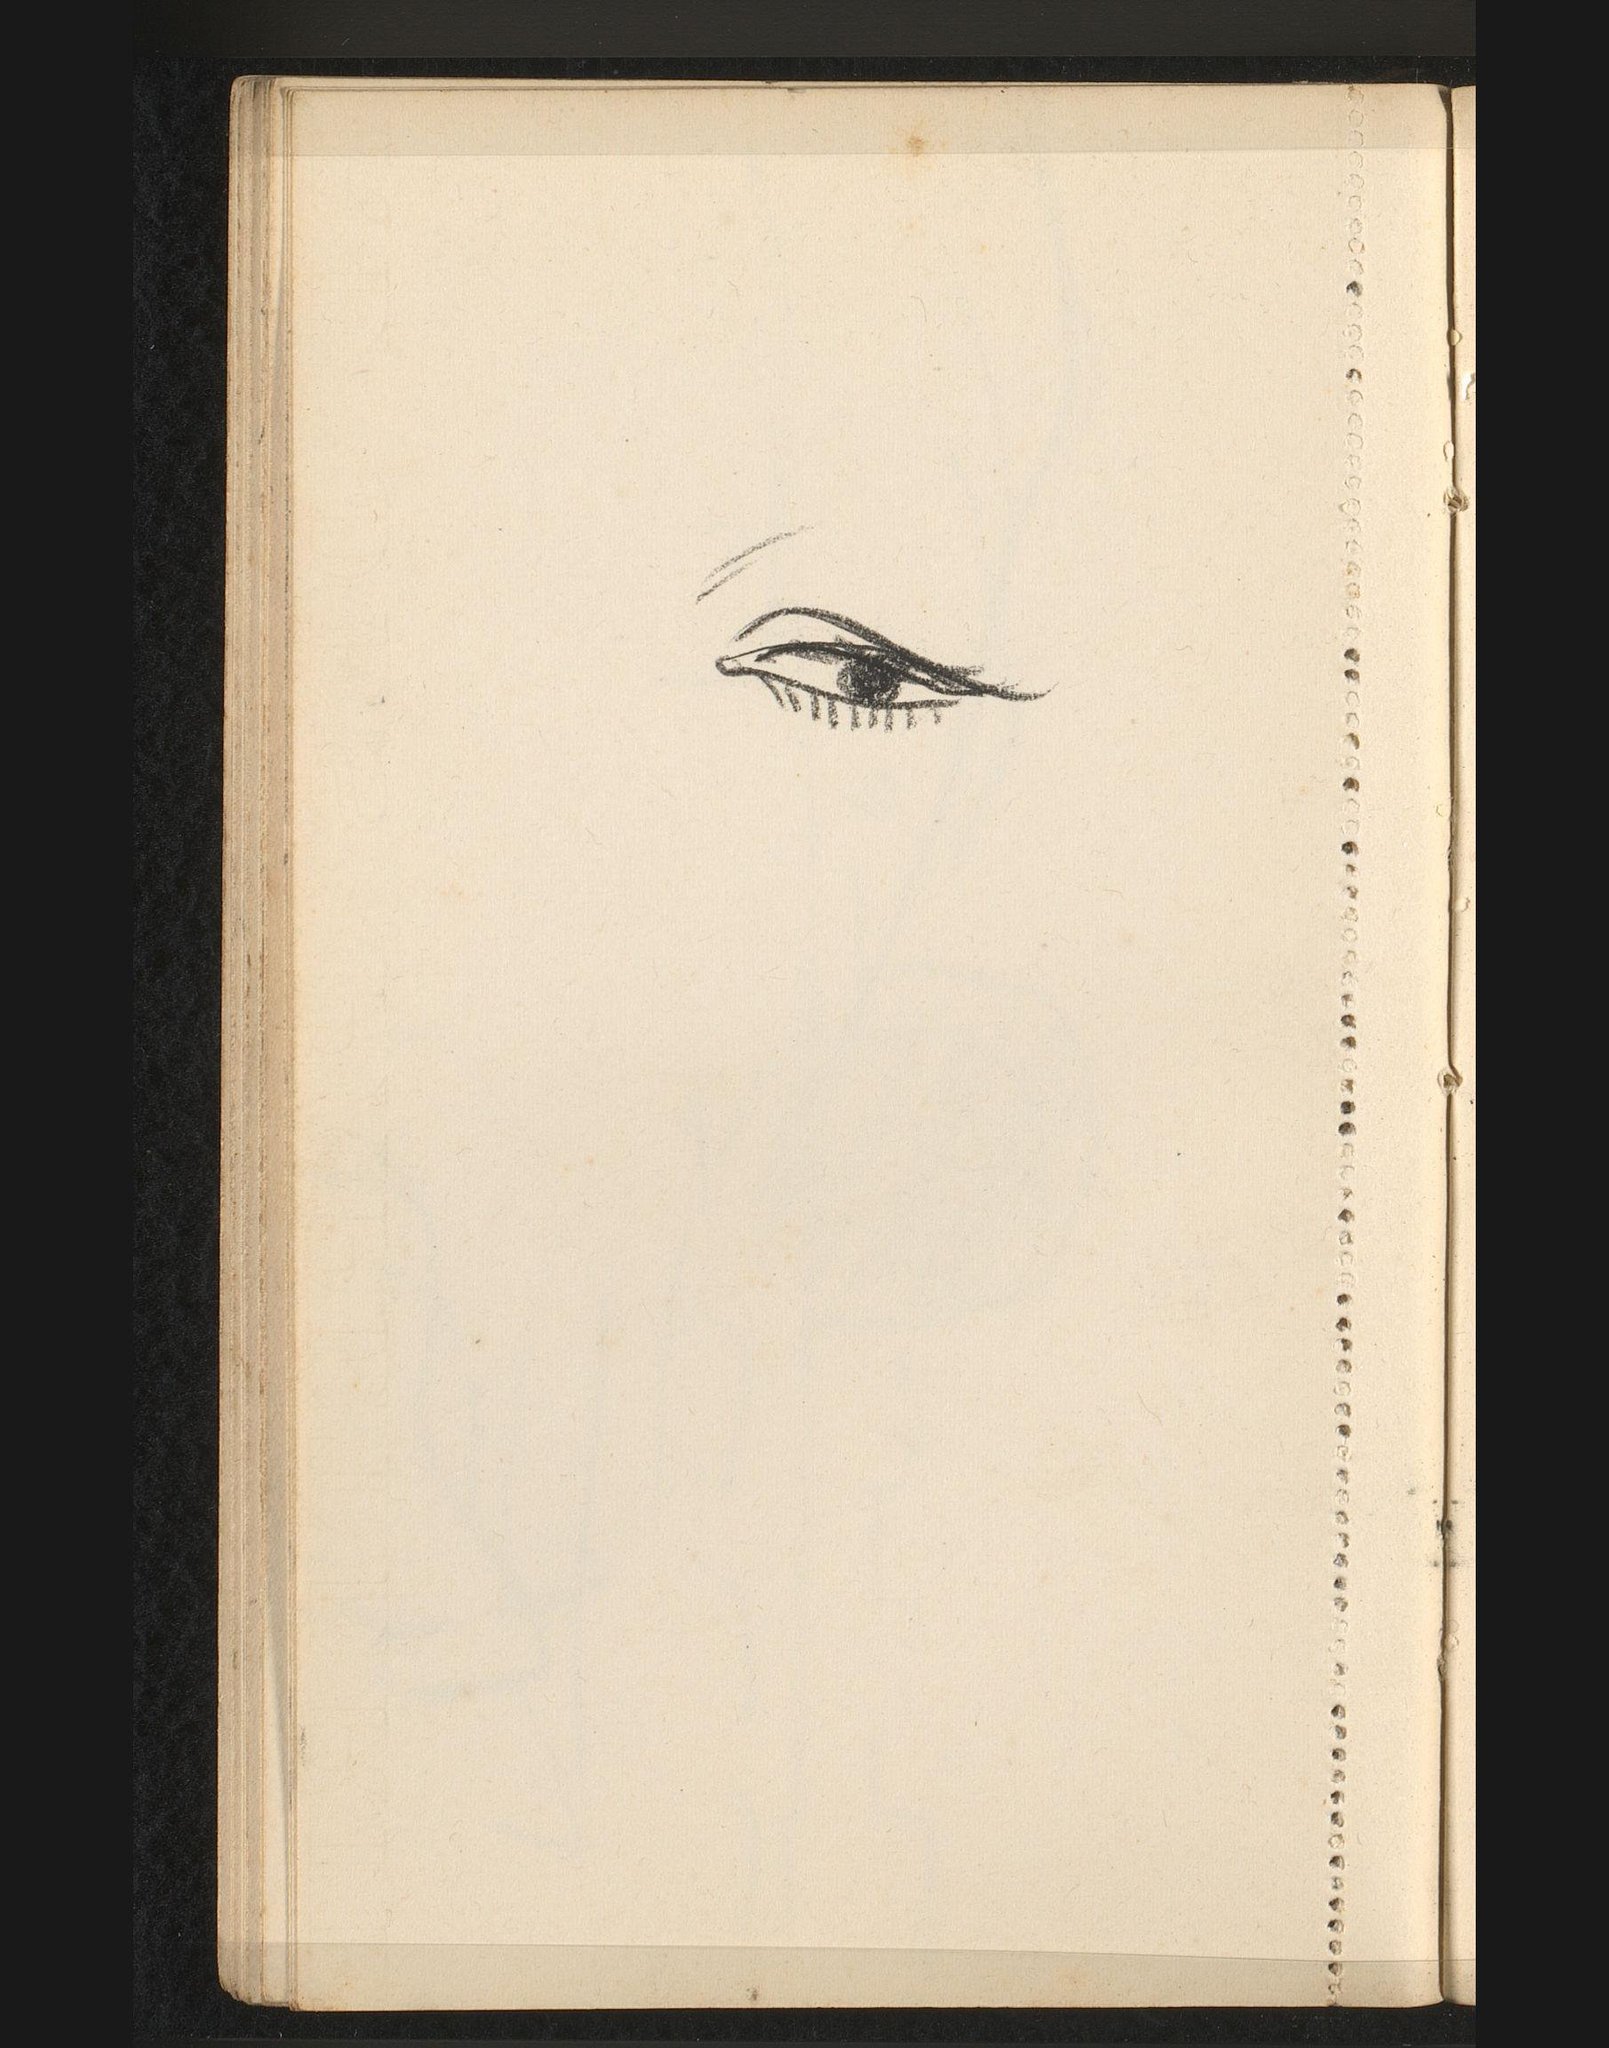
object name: sketchbook leaf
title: Oog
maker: gerrit van blaaderen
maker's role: draughtsman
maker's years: 1873-1935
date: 1908-1927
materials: chalk, paper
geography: france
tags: eyes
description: Blad 29 verso uit een schetsboek met 33 bladen.